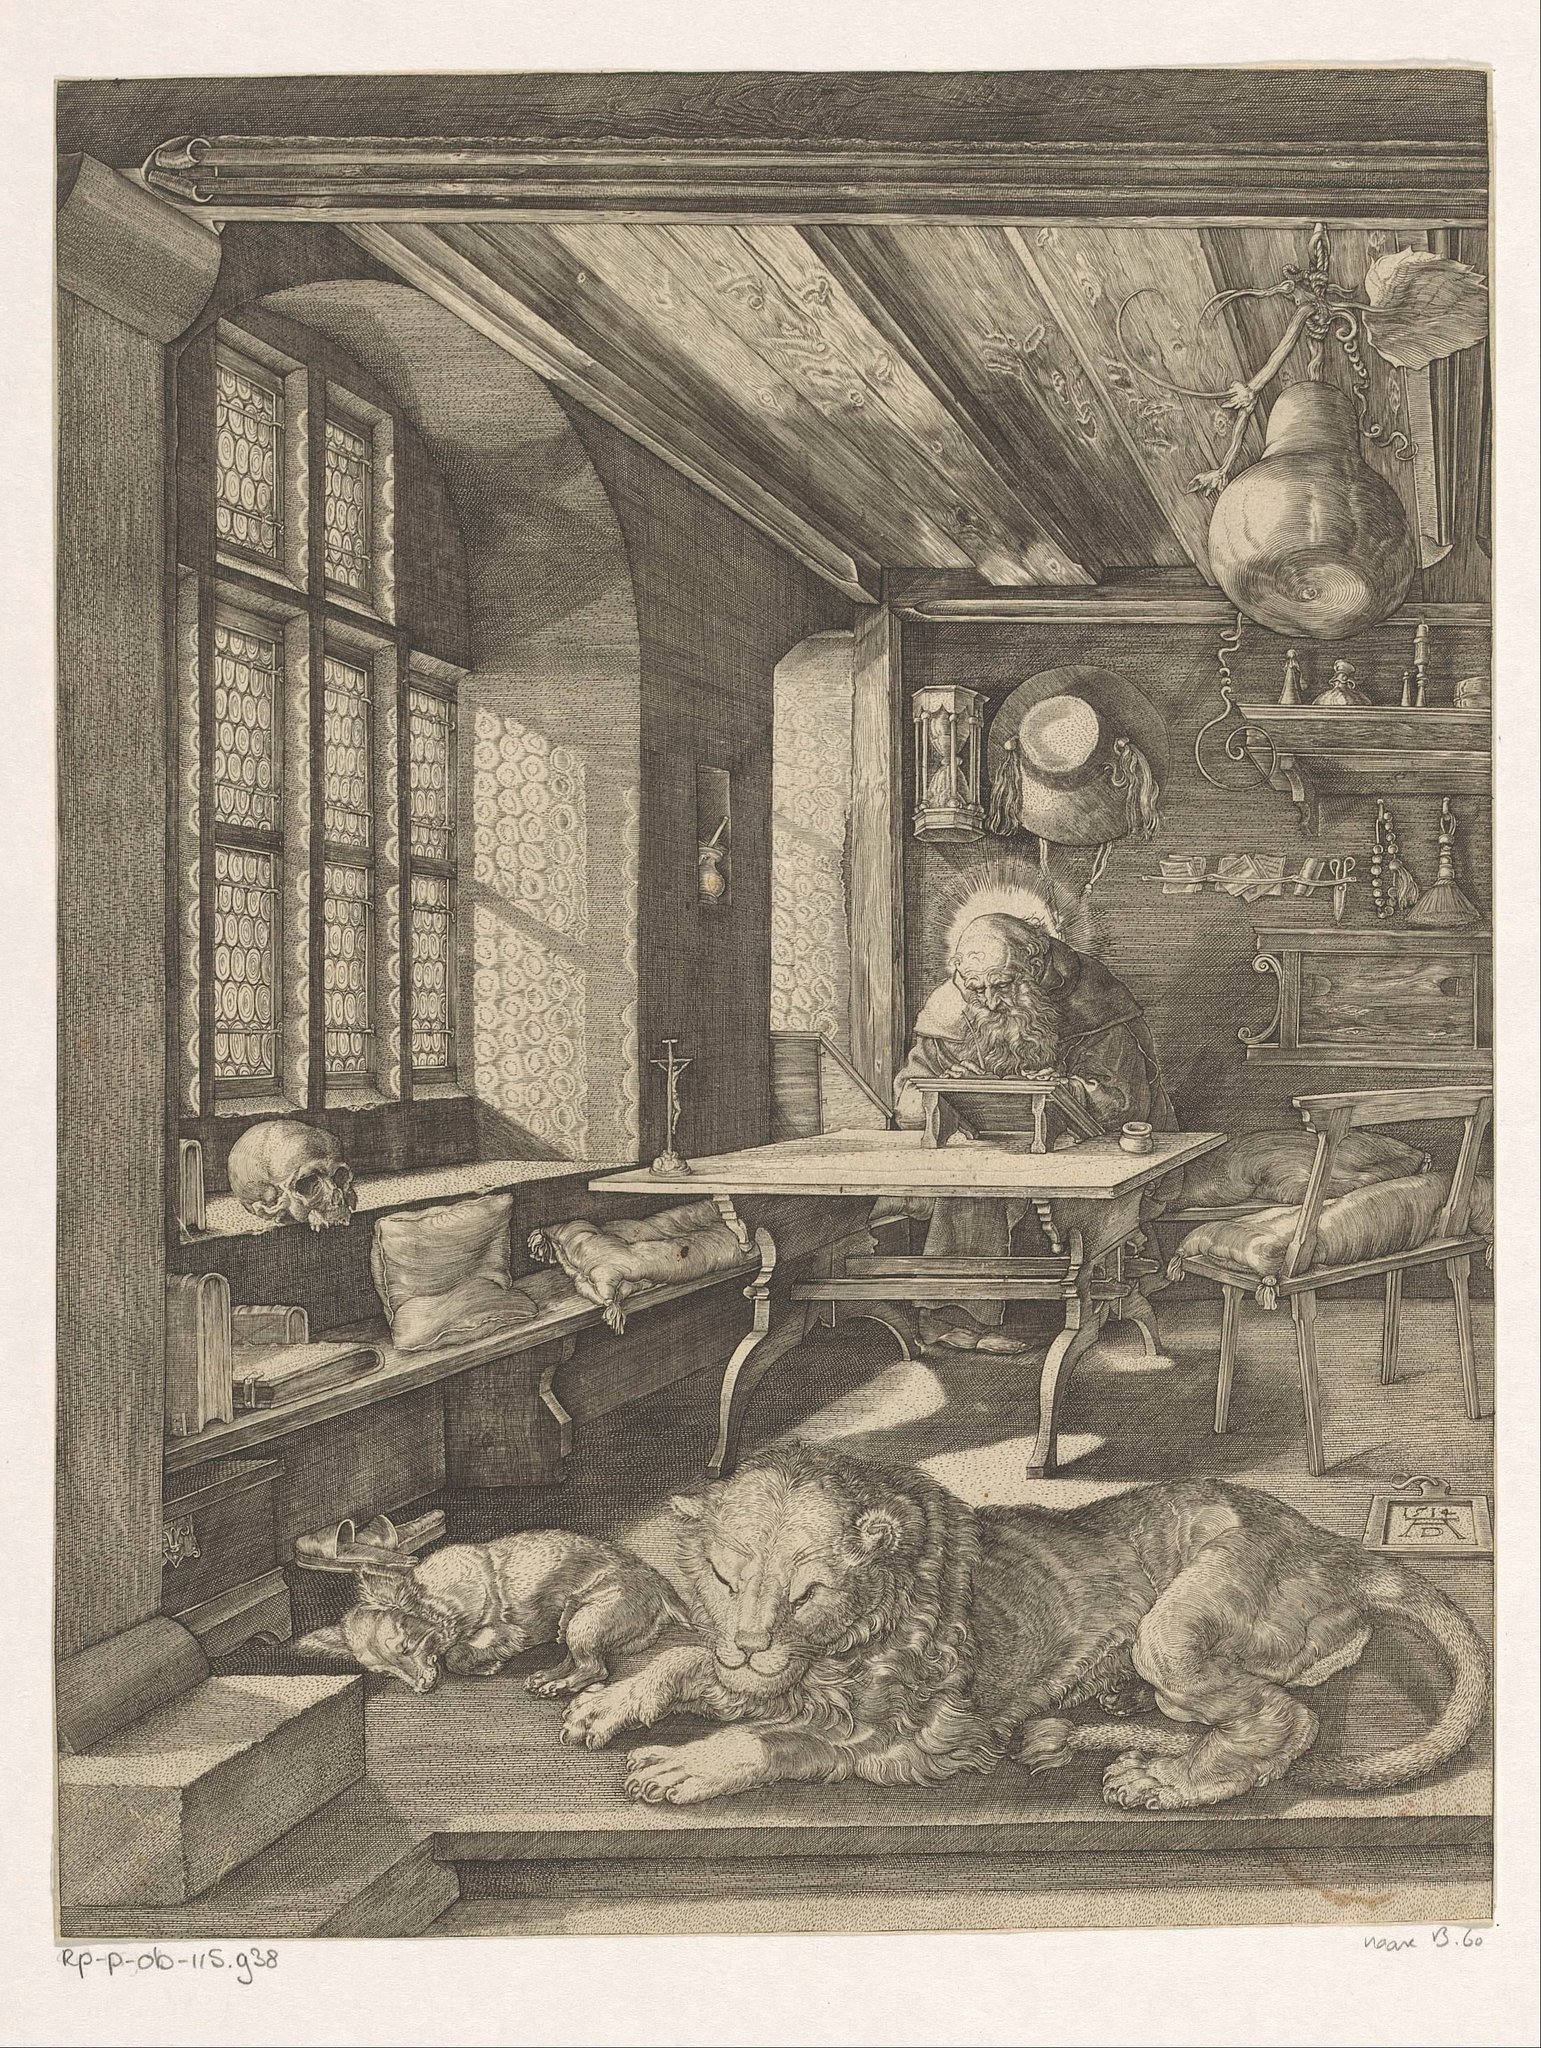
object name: print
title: Heilige Hieronymus in zijn studeervertrek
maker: Anonymous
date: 1514-1599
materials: paper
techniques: engraving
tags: fruits: pear, st. jerome as penitent in his study, study; 'studiolo'; library, beasts of prey, predatory animals: lion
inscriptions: collector's mark: Lugt 240